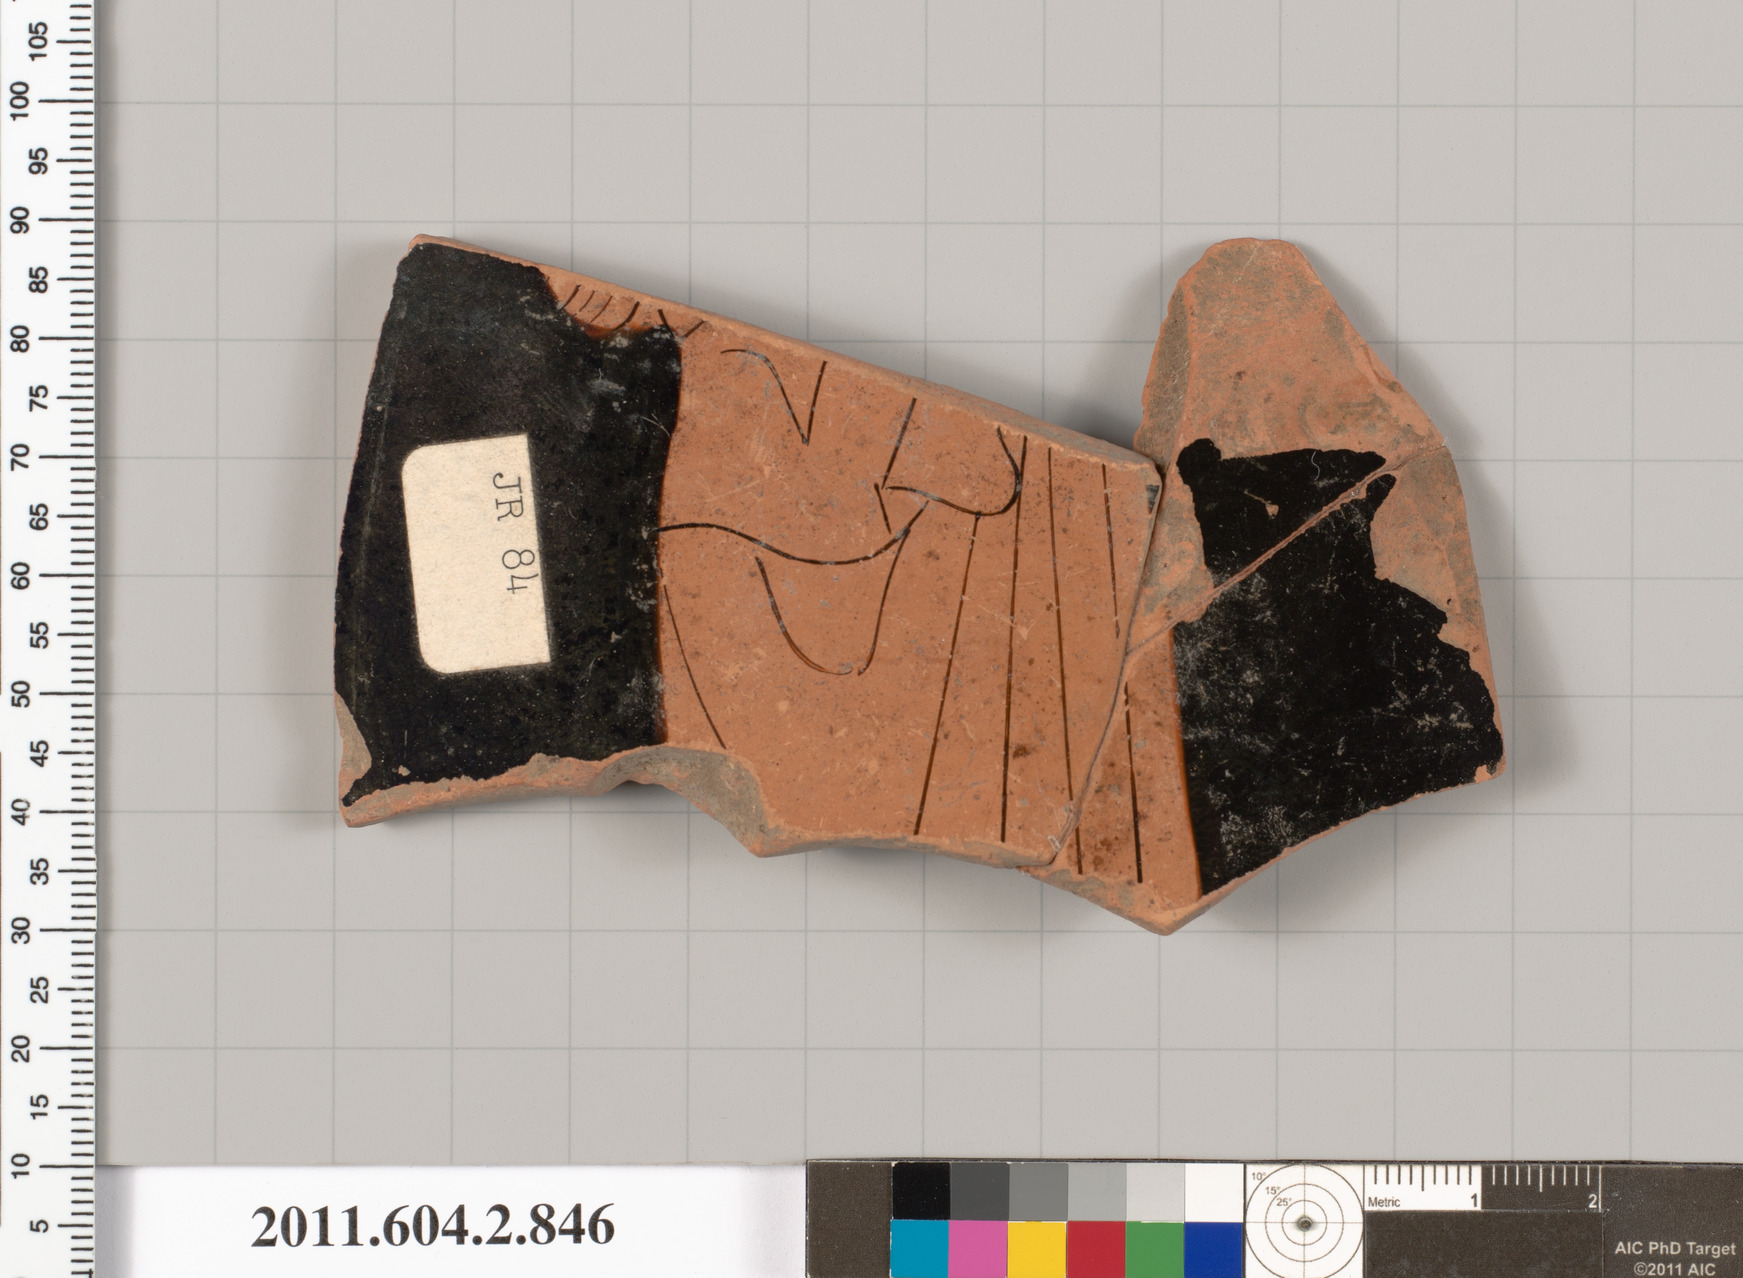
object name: bell krater fragment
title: Terracotta fragment of a bell-krater (bowl for mixing wine and water)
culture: greek, attic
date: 467-435 BCE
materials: terracotta